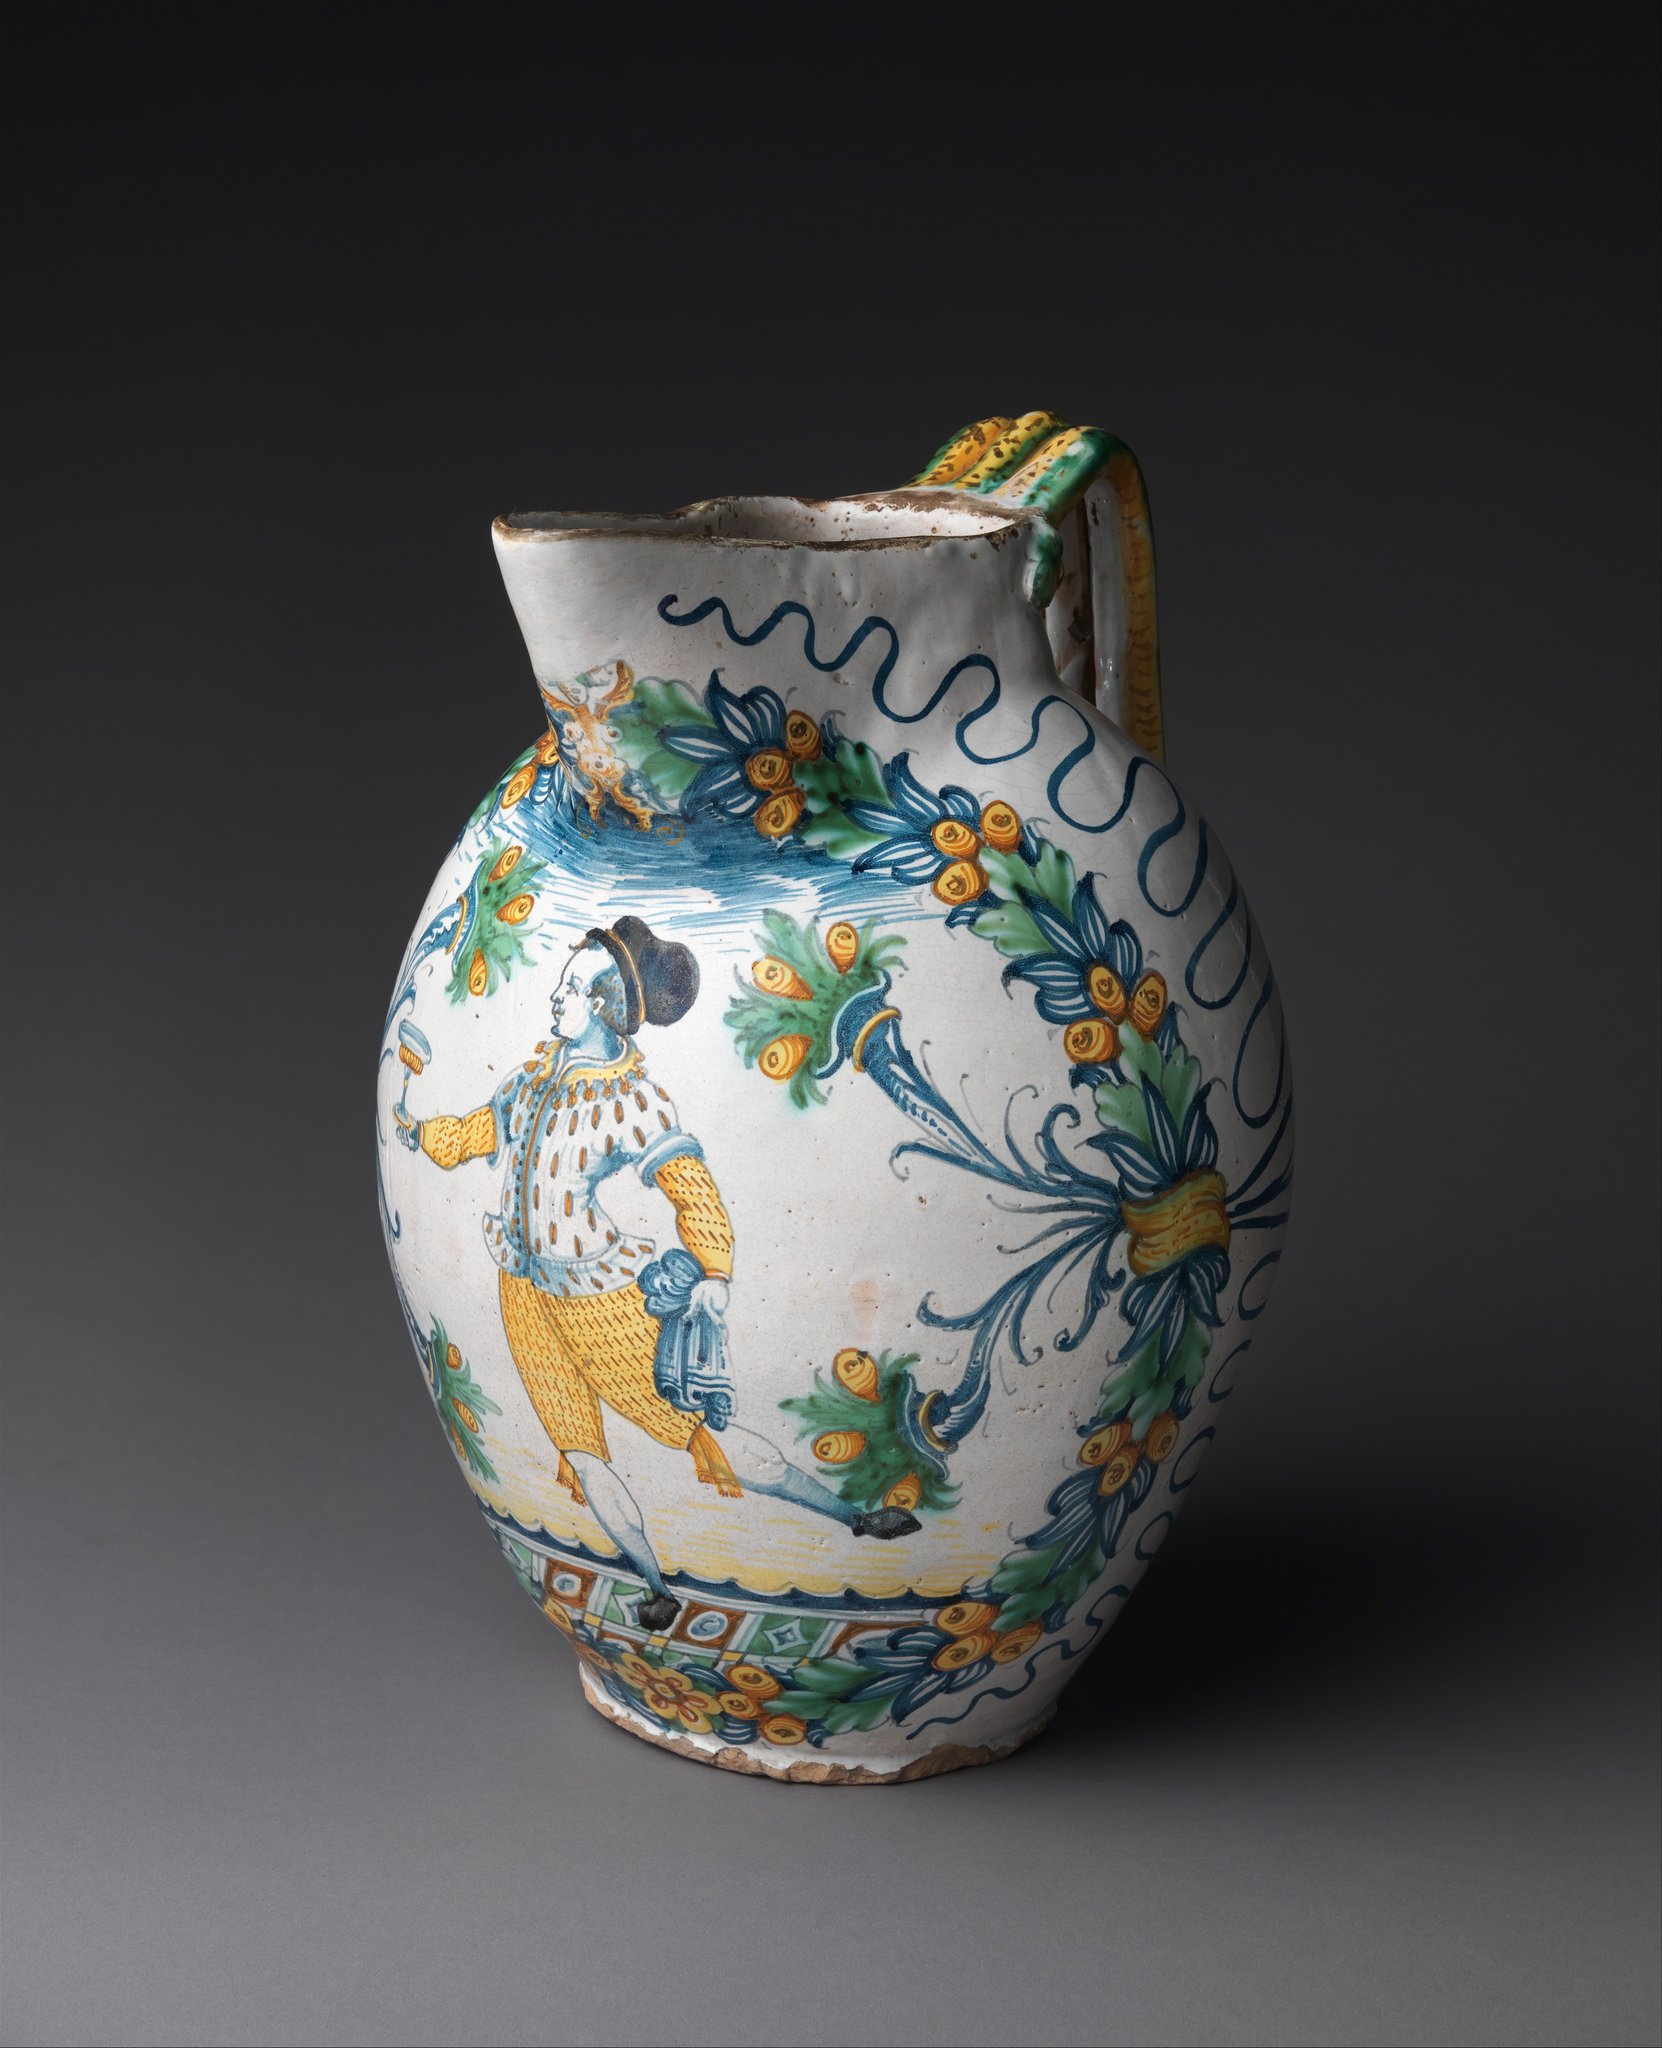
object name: jug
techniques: maiolica, glazing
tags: men,snakes,flowers